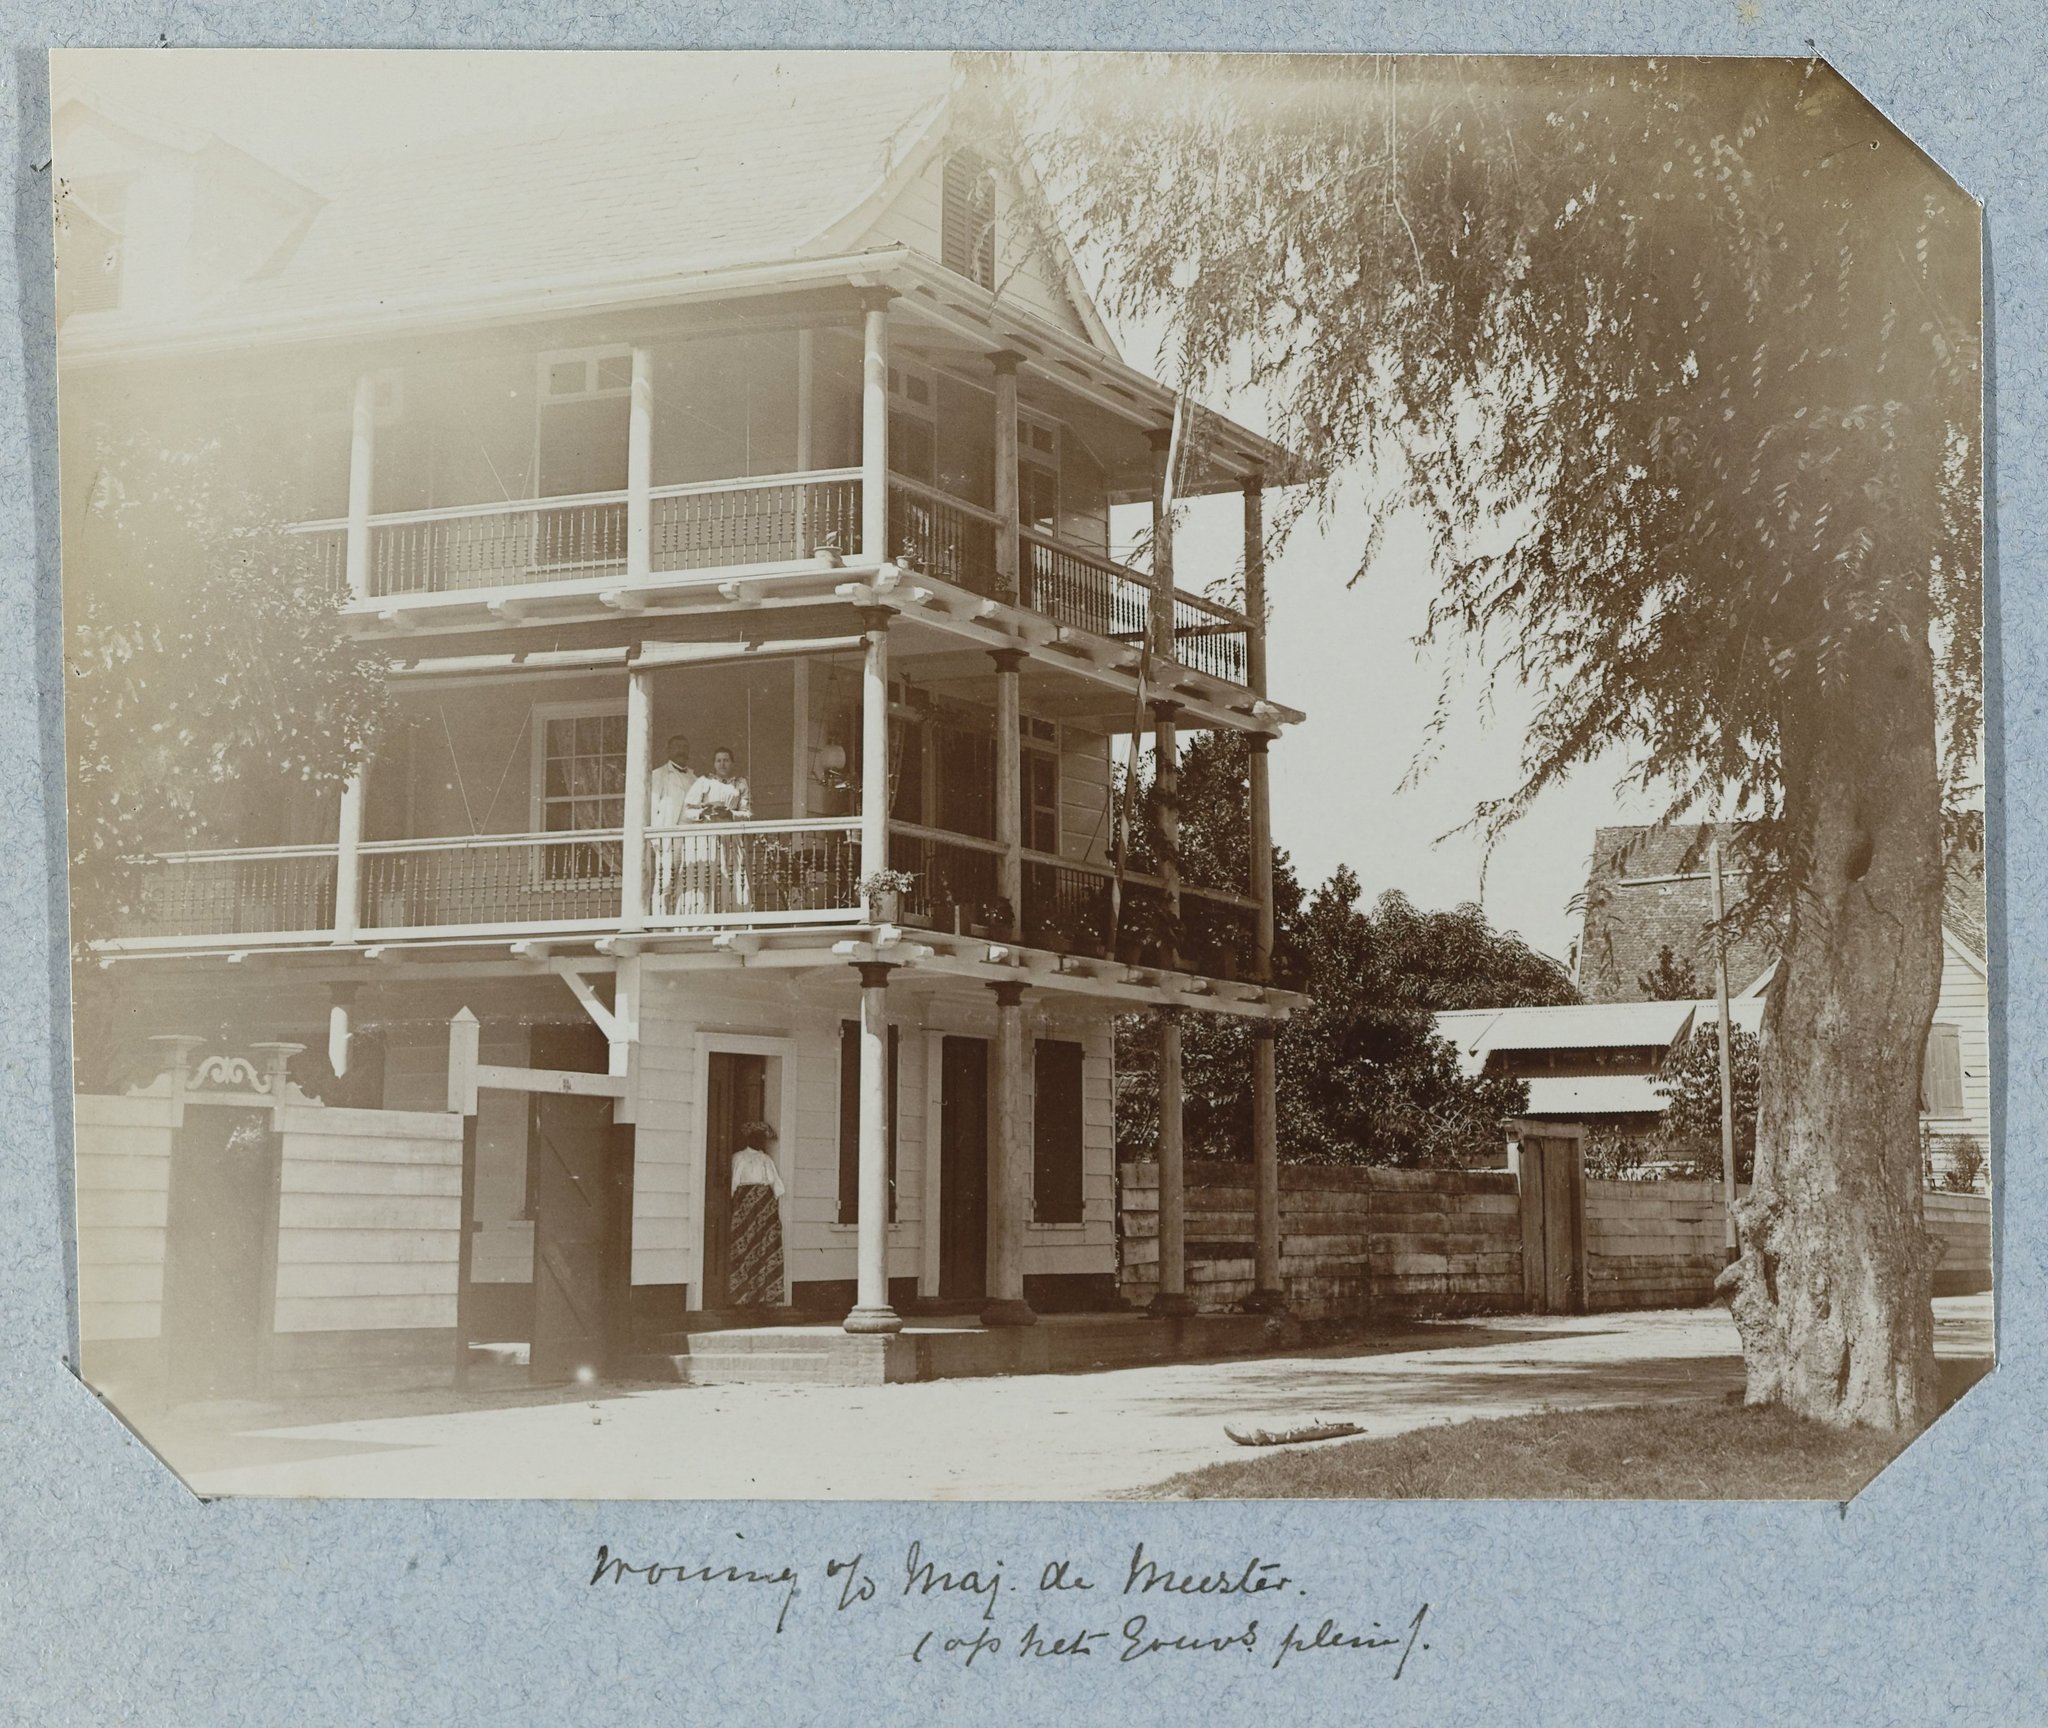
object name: photograph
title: Woning v/d Maj. de Meester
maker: théodore van lelyveld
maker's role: painter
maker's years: 1867-1954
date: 1895-1898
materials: photographic support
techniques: collodion silver print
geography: suriname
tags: detached house in city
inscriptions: inscription: ‘Woning v/d Maj de Meester. (op het Gouvs. plein).’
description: De woning van majoor De Meester aan het Gouvernementsplein te Paramaribo. Een man en vrouw staande op het balkon van de eerste verdieping, voor de deur een Surinaamse meid. Fotoafdruk in een fotoalbum van Théodore van Lelyveld over Suriname uit 1895-1898.